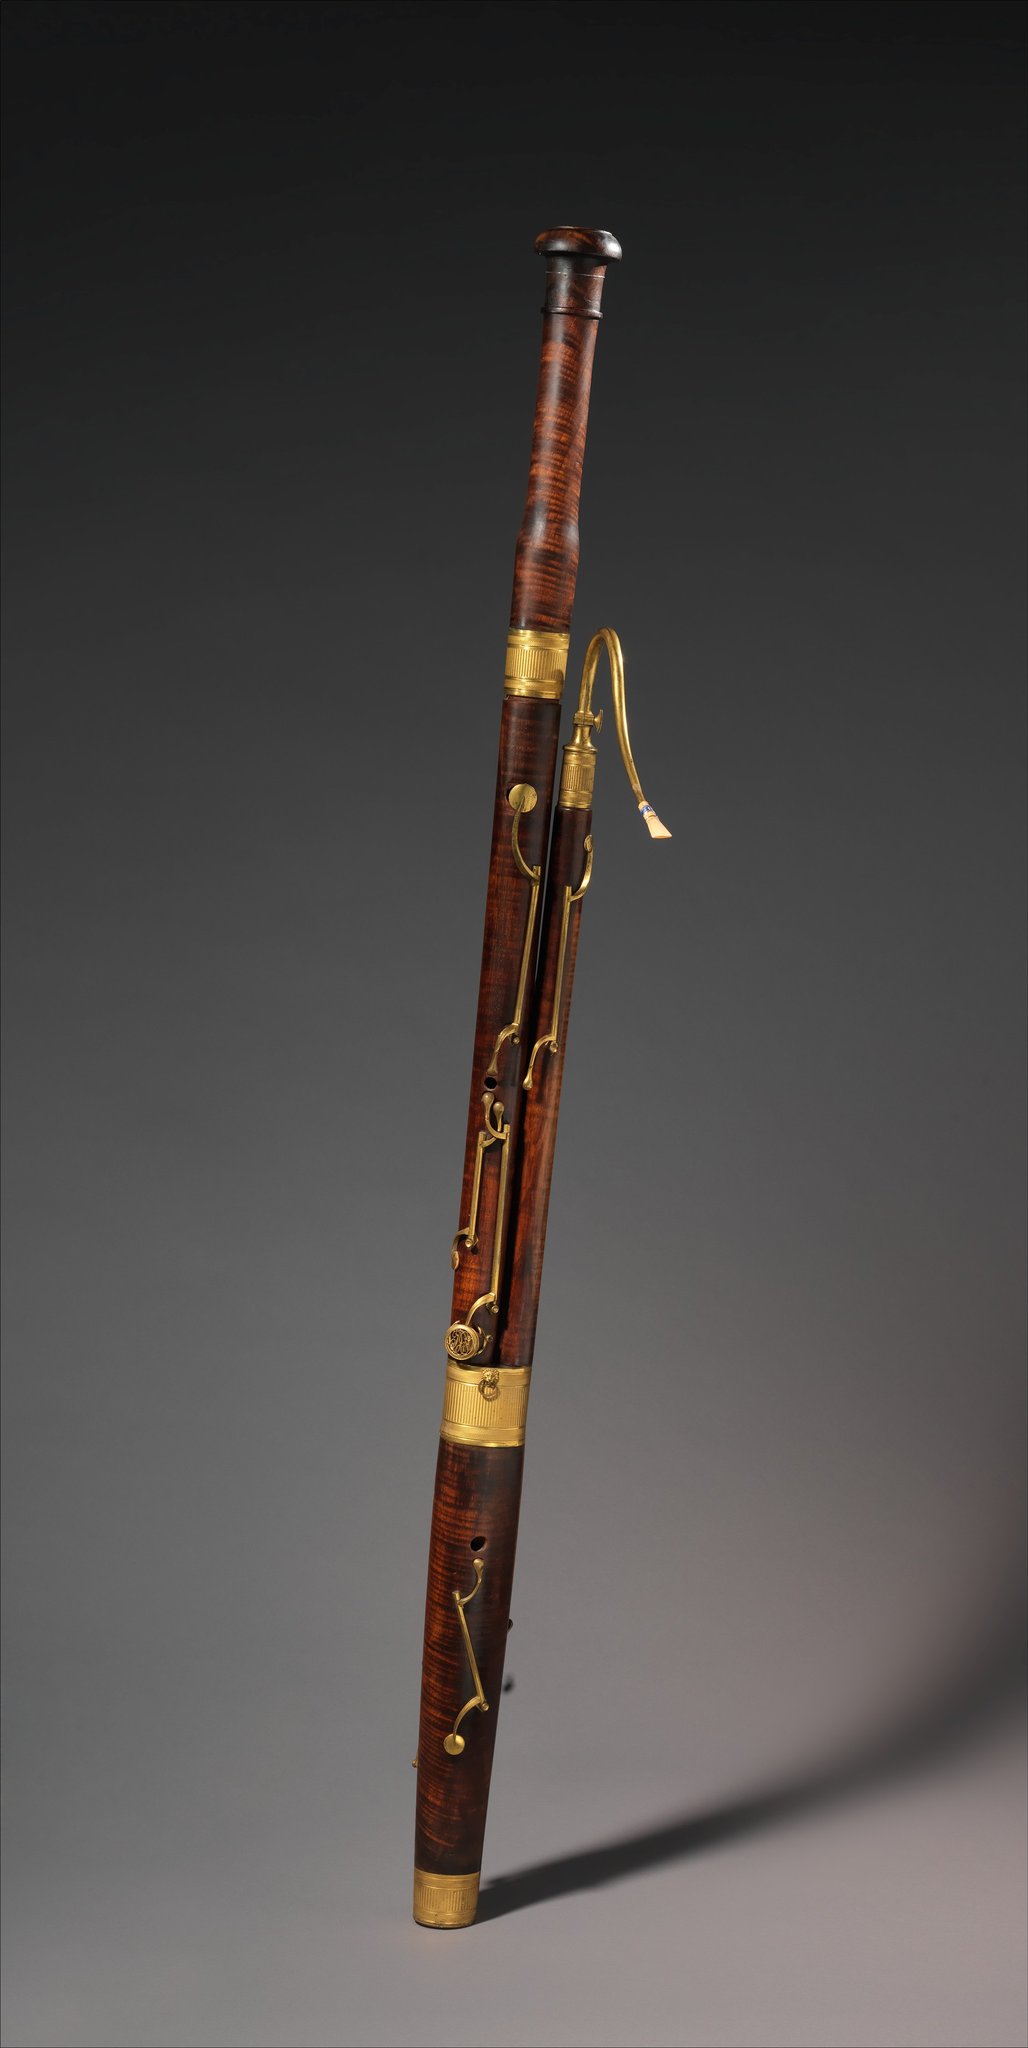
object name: bassoon in c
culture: french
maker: jean-jacques baumann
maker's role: maker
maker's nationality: french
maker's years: 1772-1845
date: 1813-1825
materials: brass, wood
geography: france